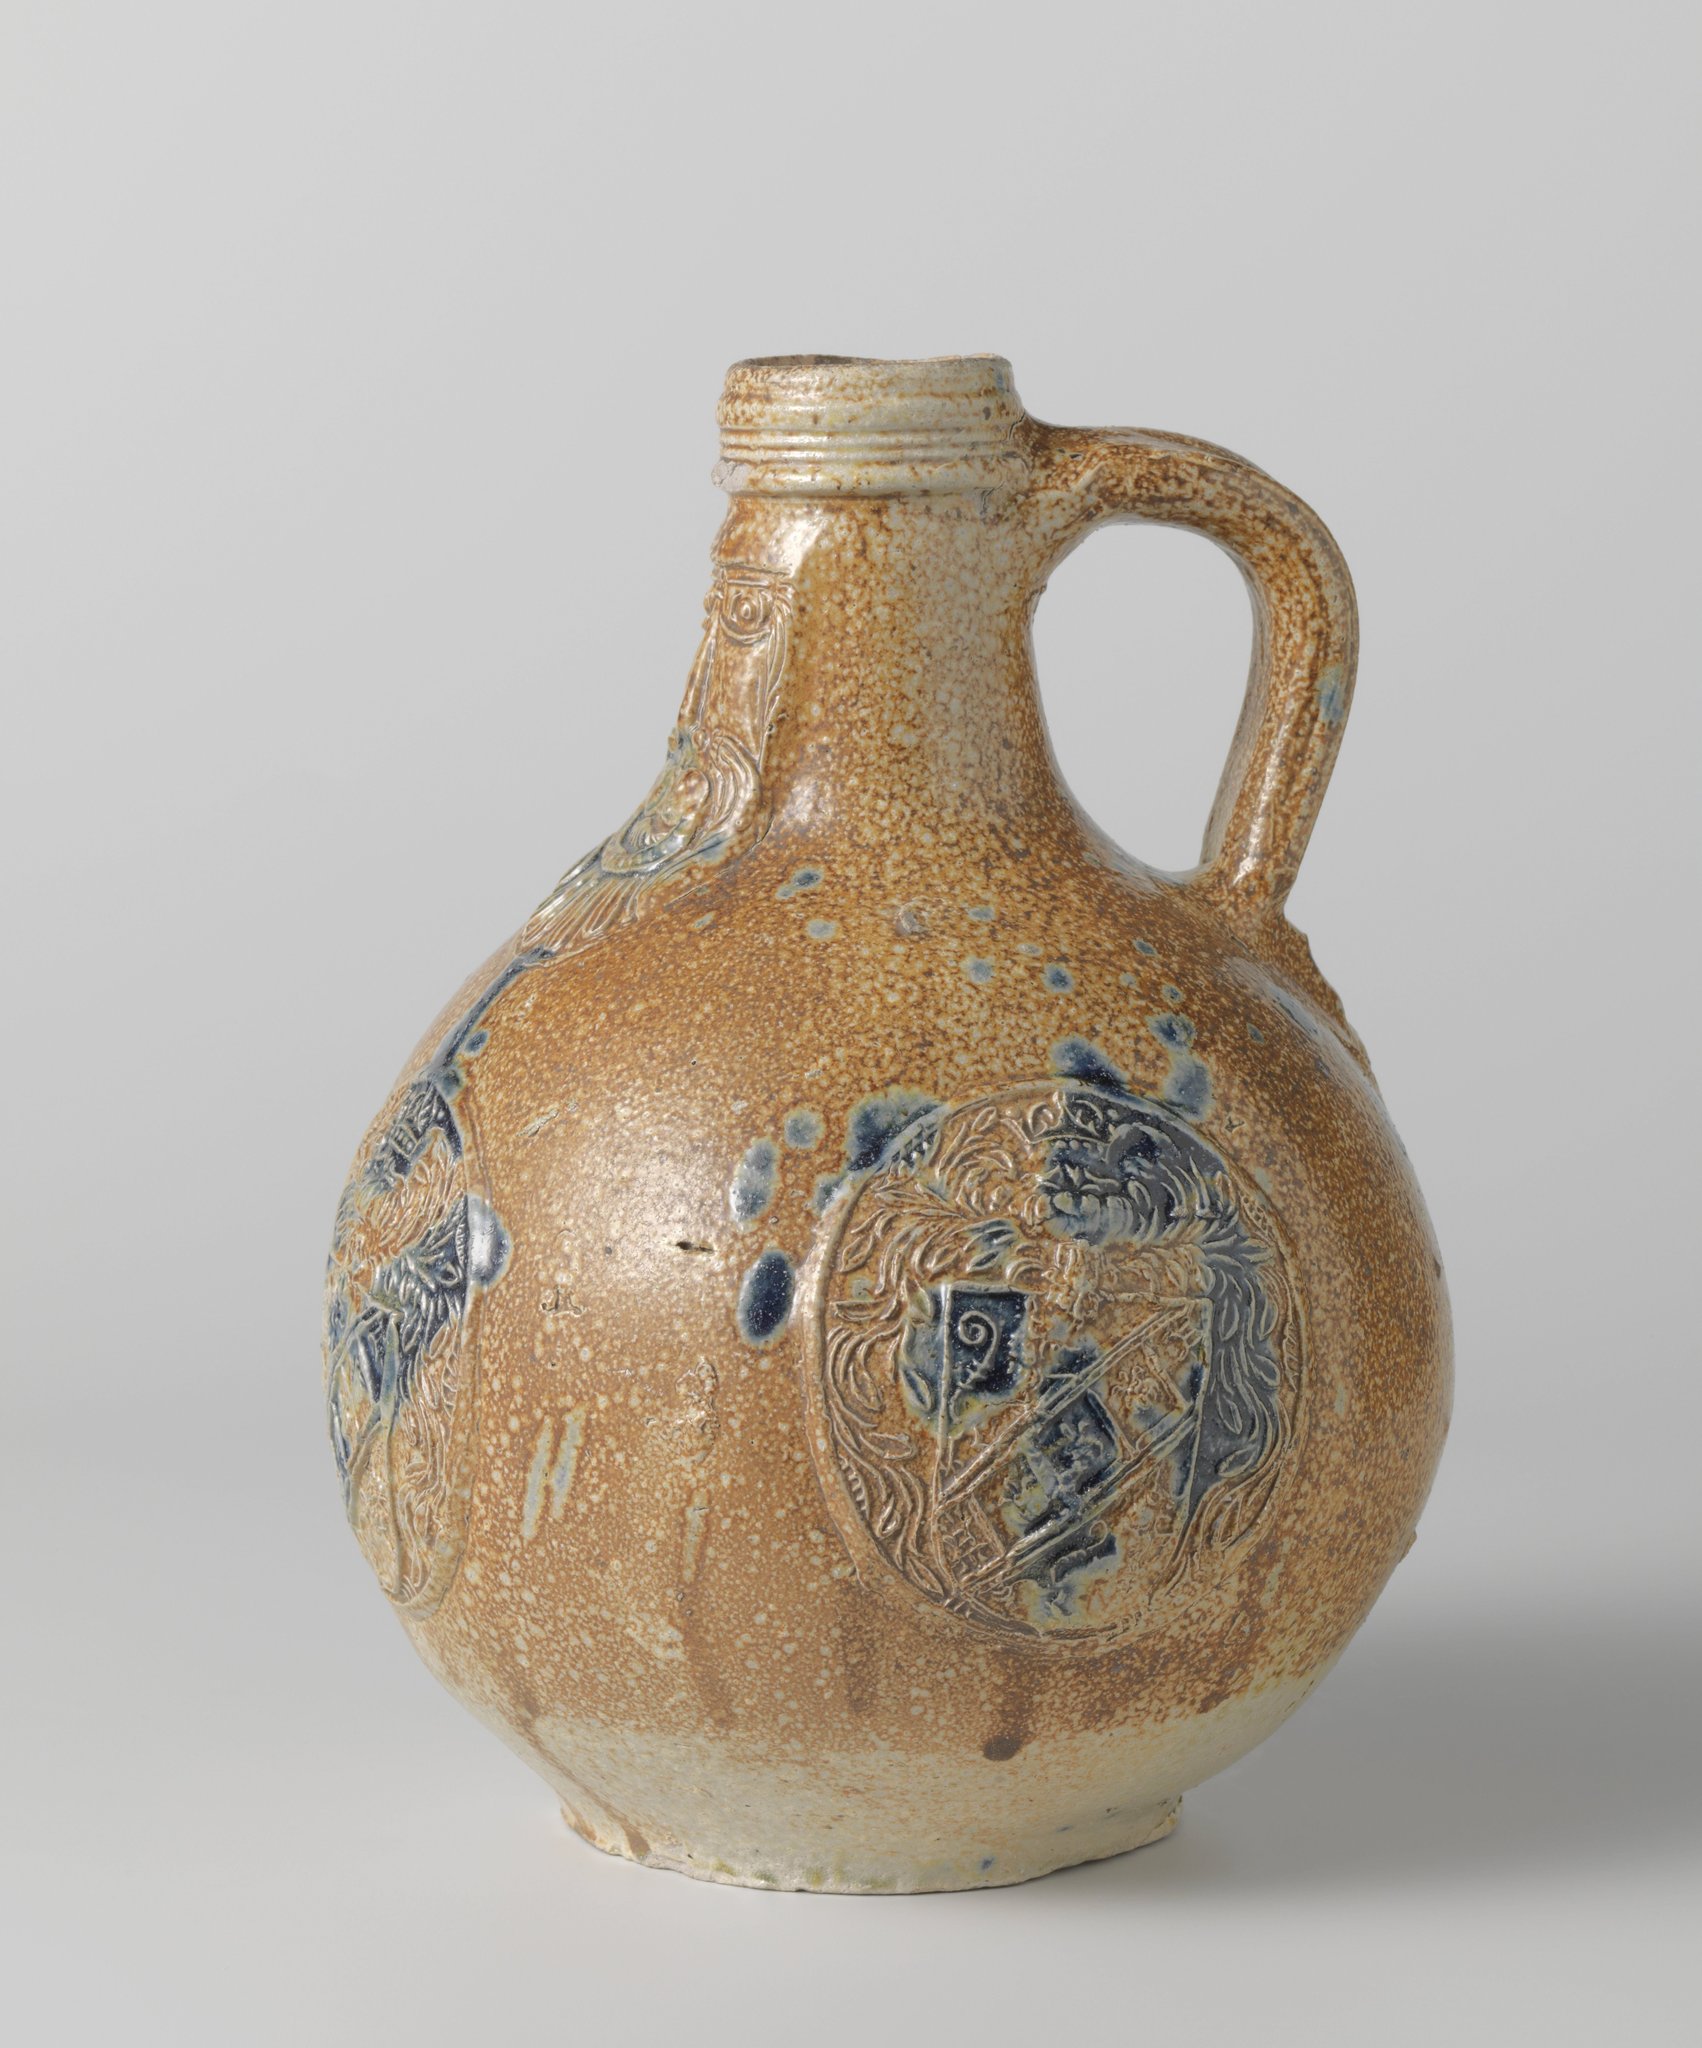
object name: jug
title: Jug (Bartmann jug) with a coat of arms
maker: Anonymous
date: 1625-1674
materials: cobalt, engobe, glaze, stoneware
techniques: firing, forming, relief, turning, vitrification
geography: frechen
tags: beard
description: Kruik (baardmankruik) van steengoed op standvlak met een bolvormig lichaam en smalle nek. Het C-vormige oor is bevestigd aan de nek en de schouder. Profielen op de nek. Bedekt met een bruine engobe en kobaltblauw. Op de buik in reliëf driemaal een gedrukt en opgelegd medaillon met een gekroond wapen. Op de nek, doorlopend op de schouder een baardman. Keulen/ Frechen.